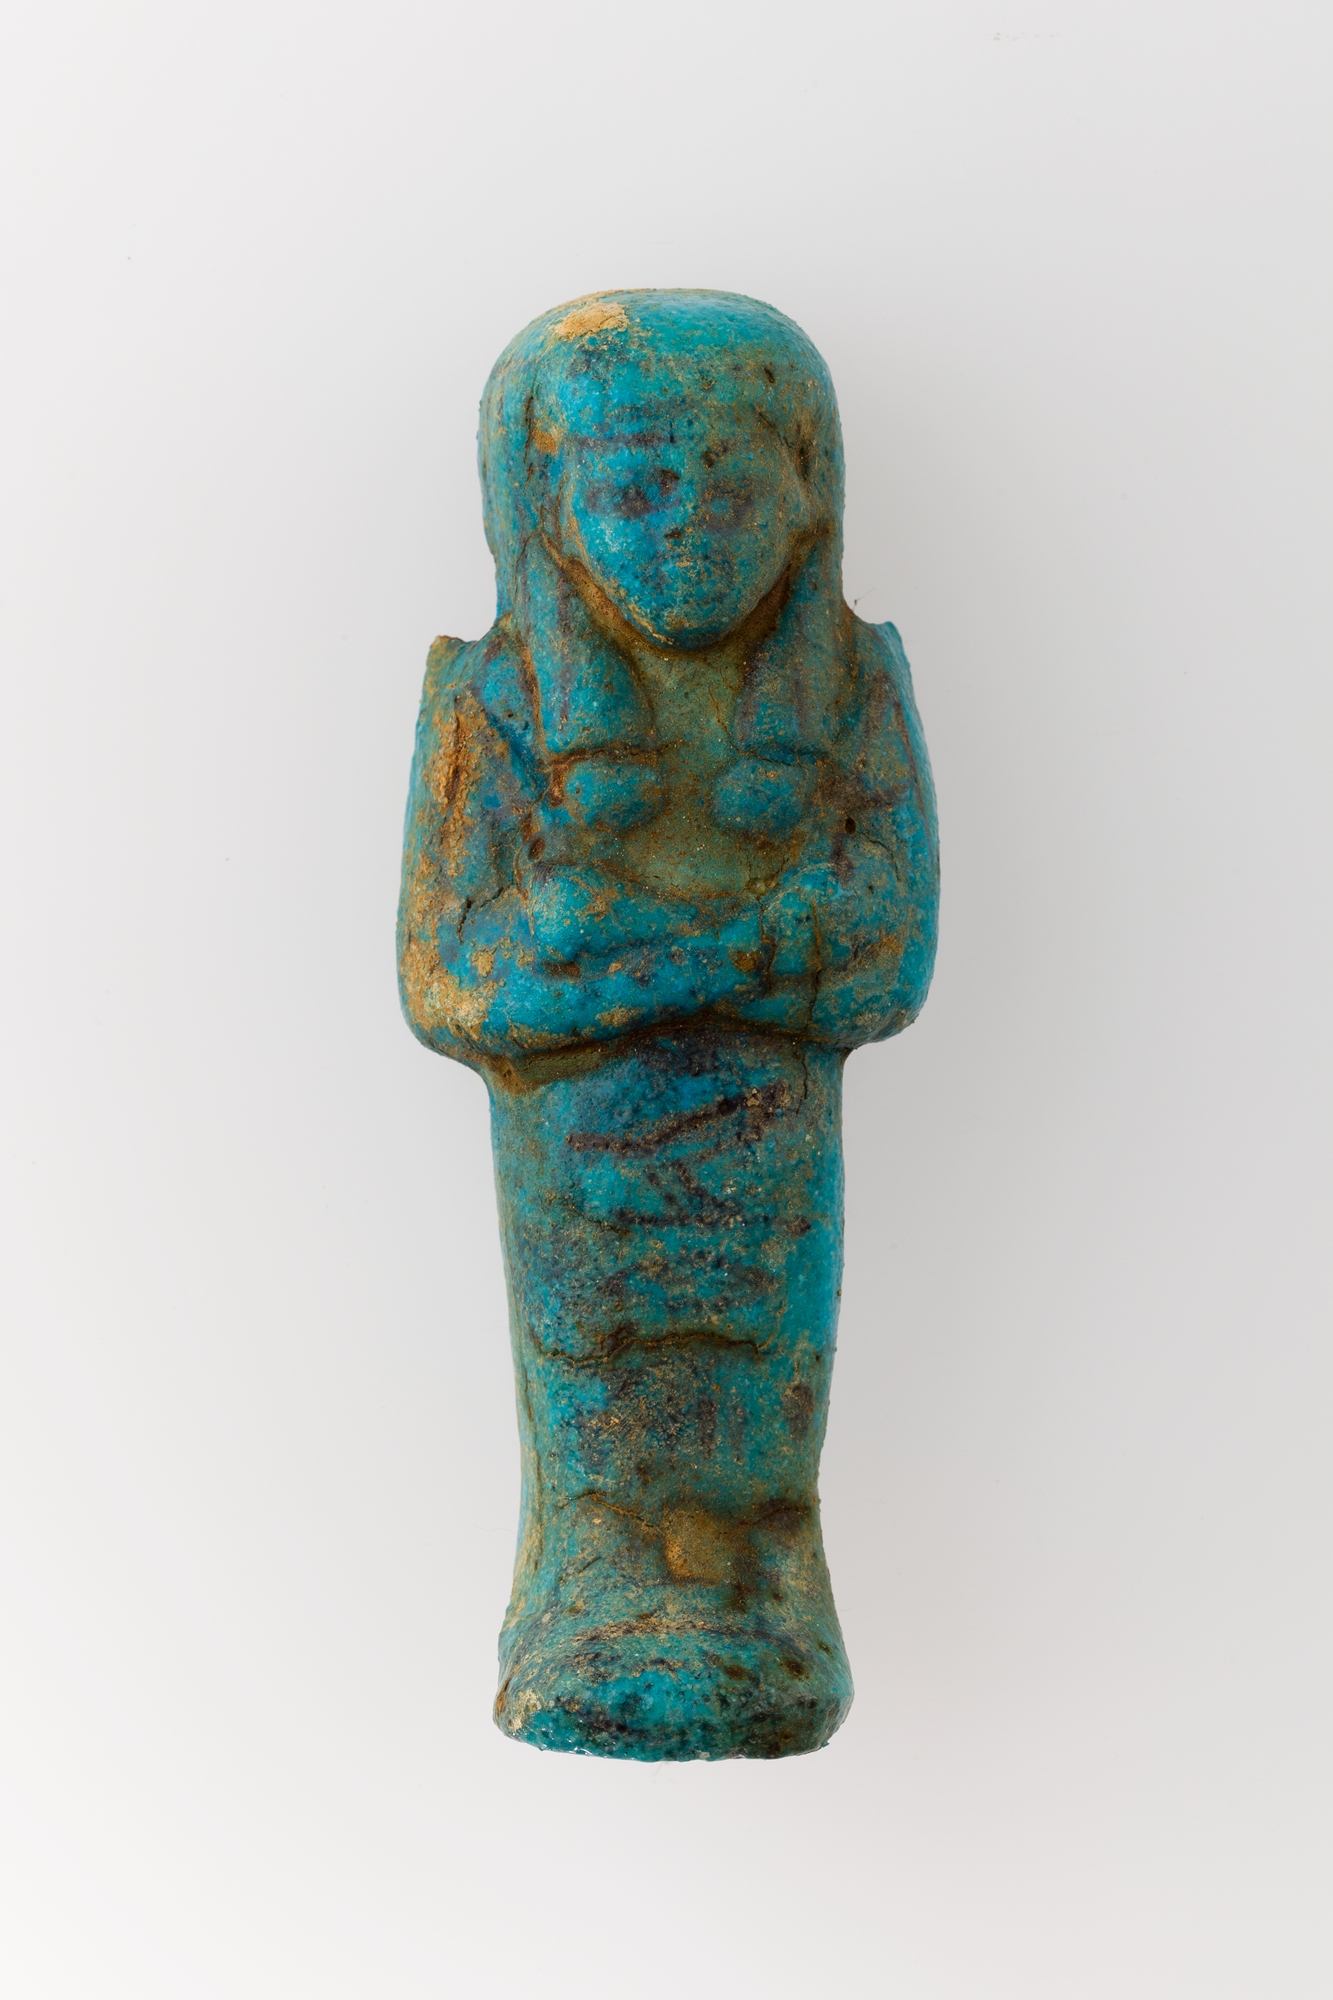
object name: shabti, henettawy c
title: Worker Shabti of Henettawy (C), Daughter of Isetemkheb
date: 990-970 BCE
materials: faience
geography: egypt